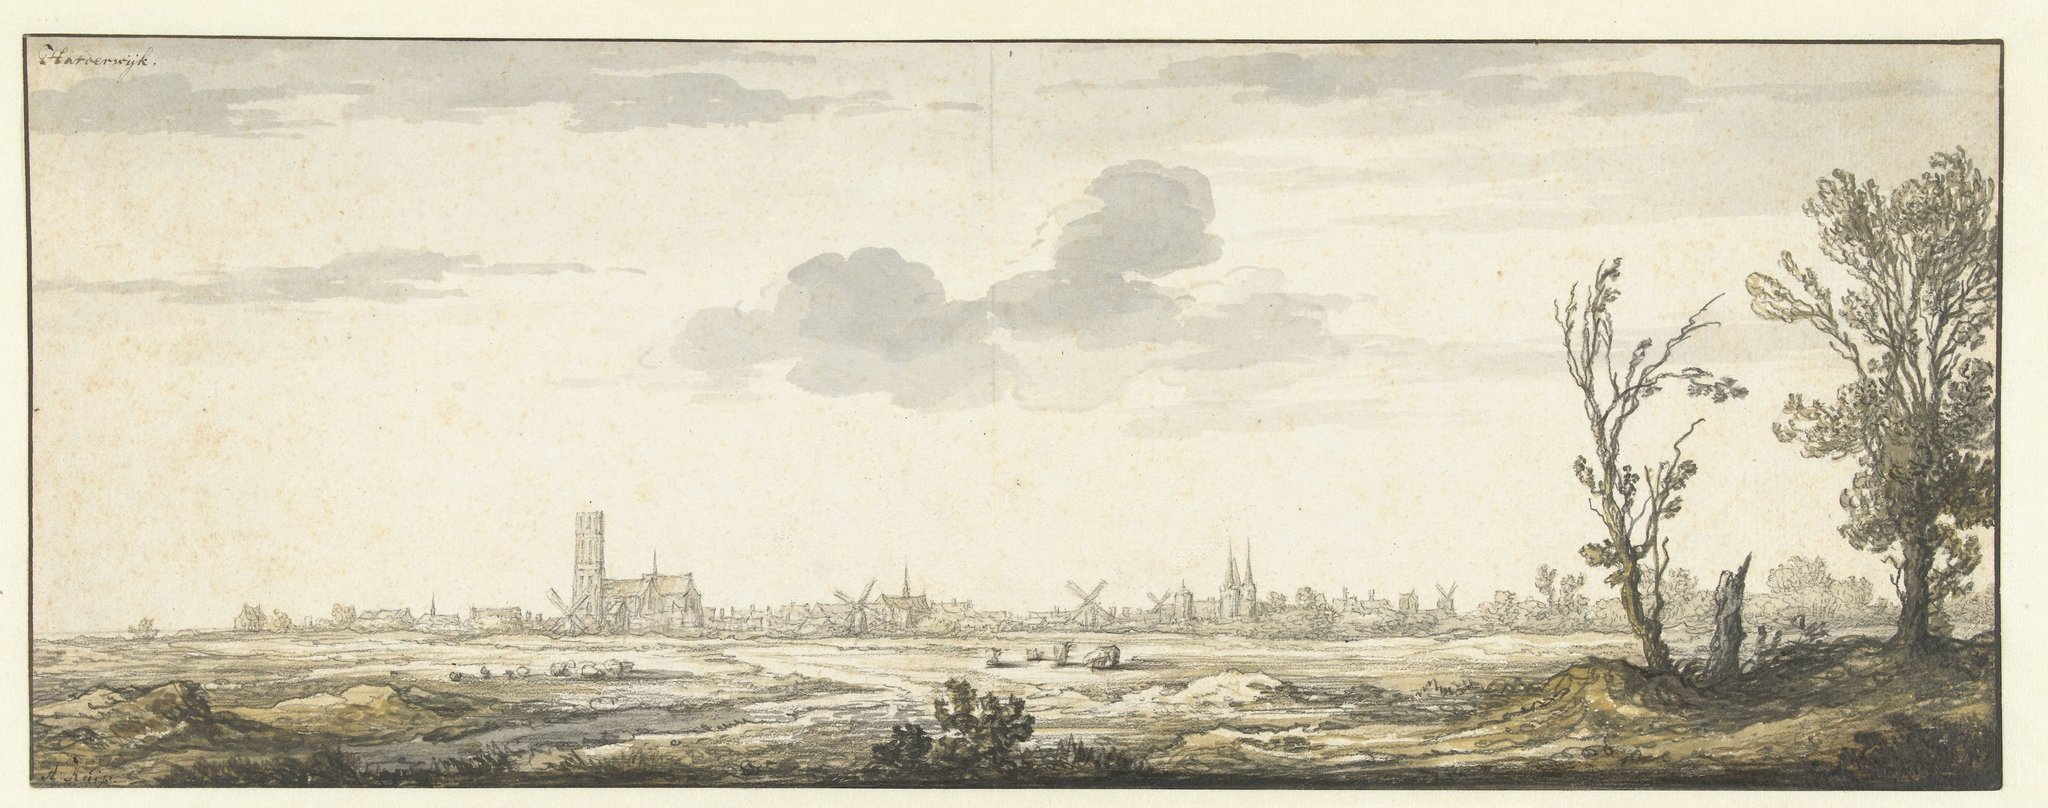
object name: drawing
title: Harderwijk.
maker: aelbert cuyp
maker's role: draughtsman, painter, print maker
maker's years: 1620-1691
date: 1630-1691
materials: chalk, gum arabic, paper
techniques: brush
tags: harderwijk